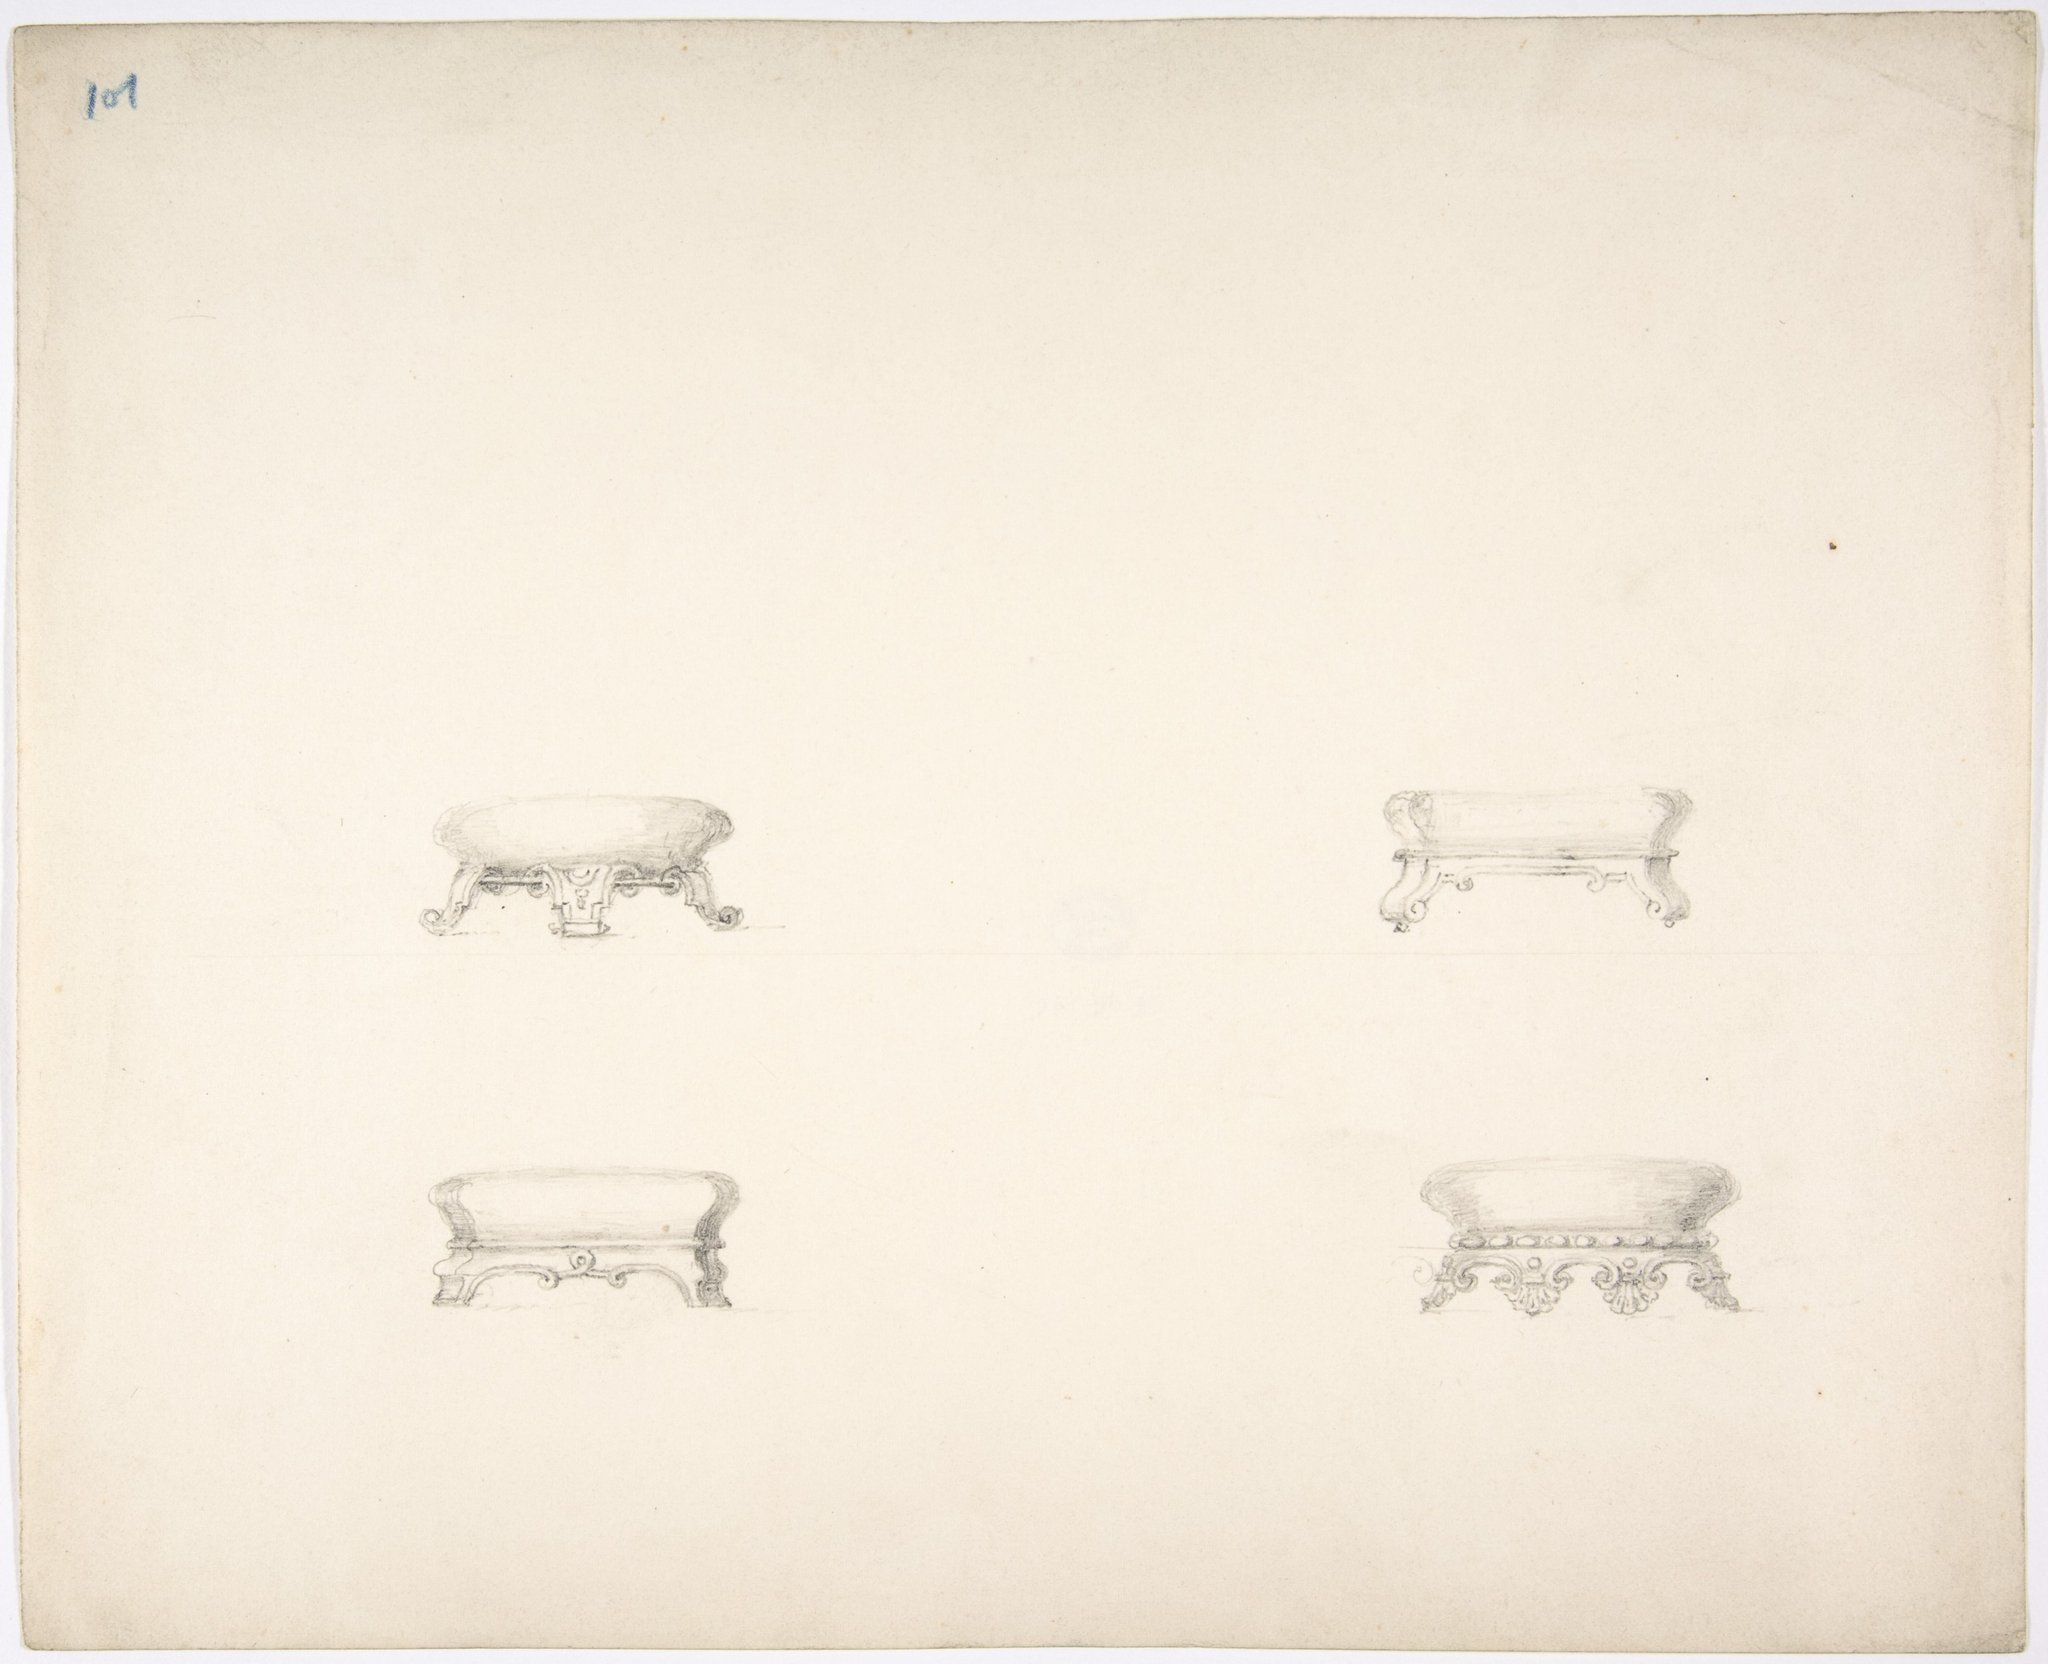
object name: drawing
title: Design for Four Footstools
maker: anonymous, british, 19th century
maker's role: artist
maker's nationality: british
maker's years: 1800-1900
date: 1801-1833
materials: graphite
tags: stools